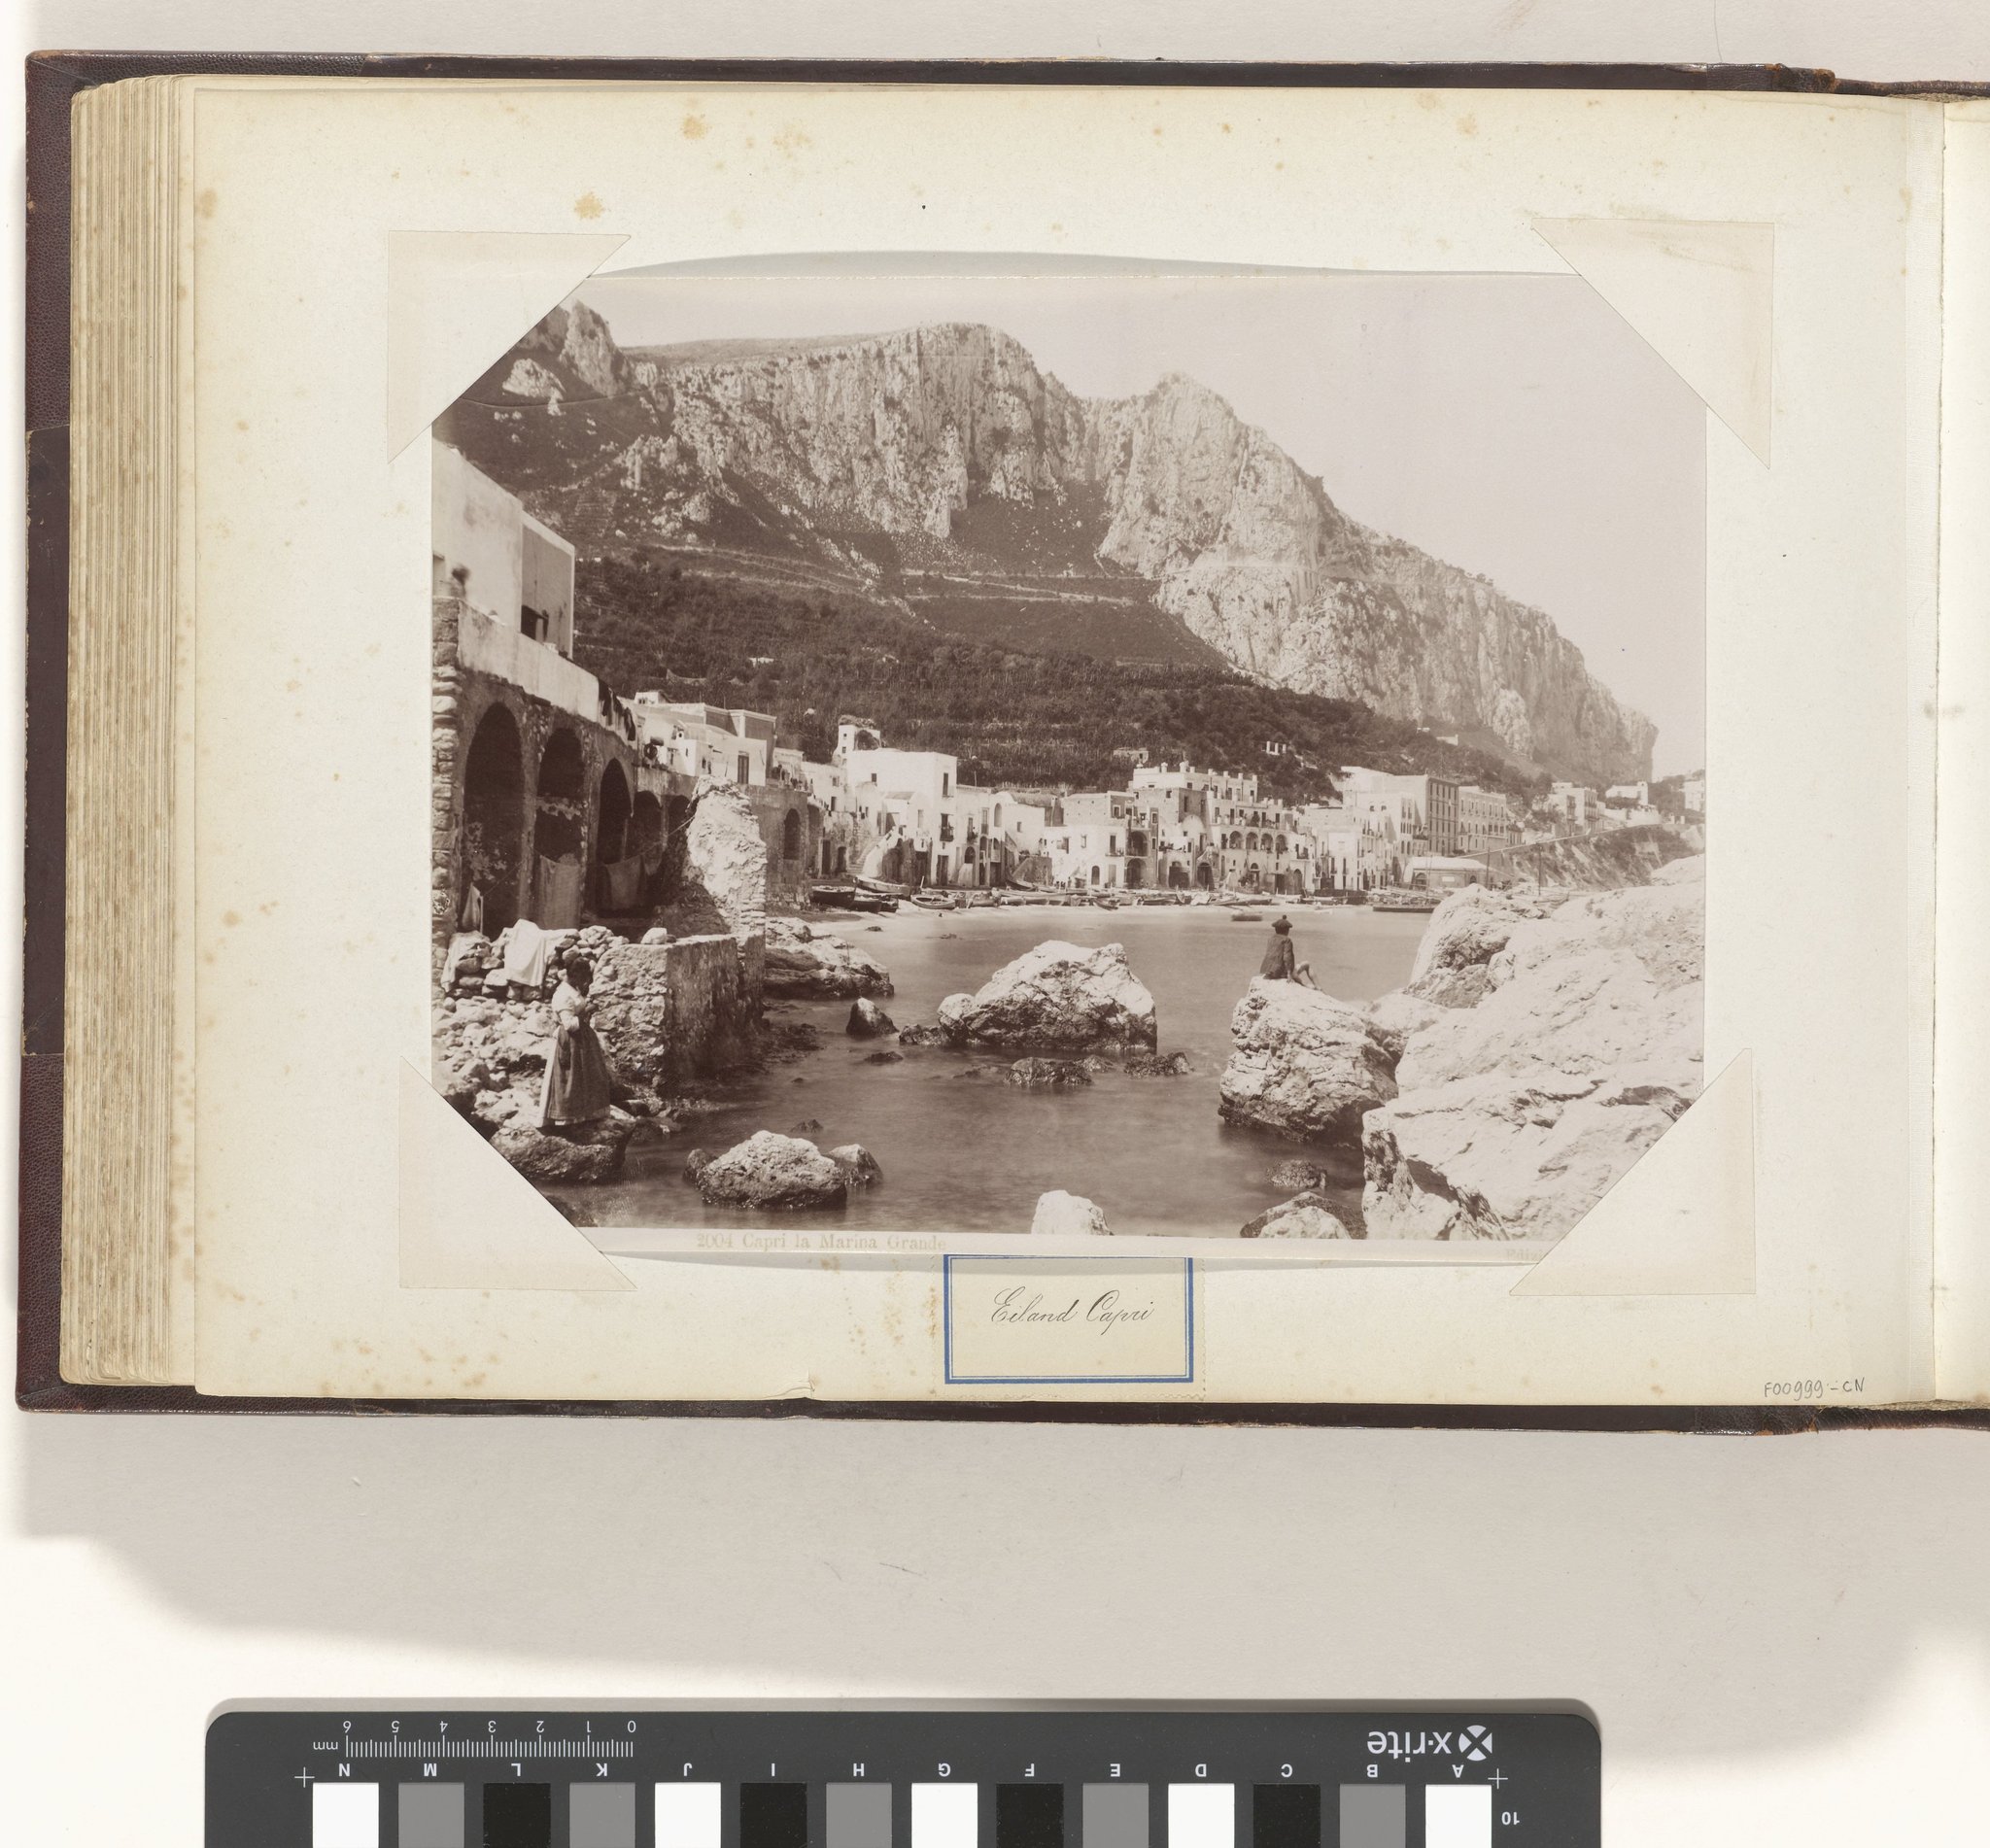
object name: photograph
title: Capri la Marina Grande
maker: Anonymous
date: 1880-1920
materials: paper, photographic support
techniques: albumen print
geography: capri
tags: harbour, capri, isola di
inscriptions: negative number: ‘2004’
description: Onderdeel van Album met 191 foto's van een reis naar en door Zuid-Afrika.